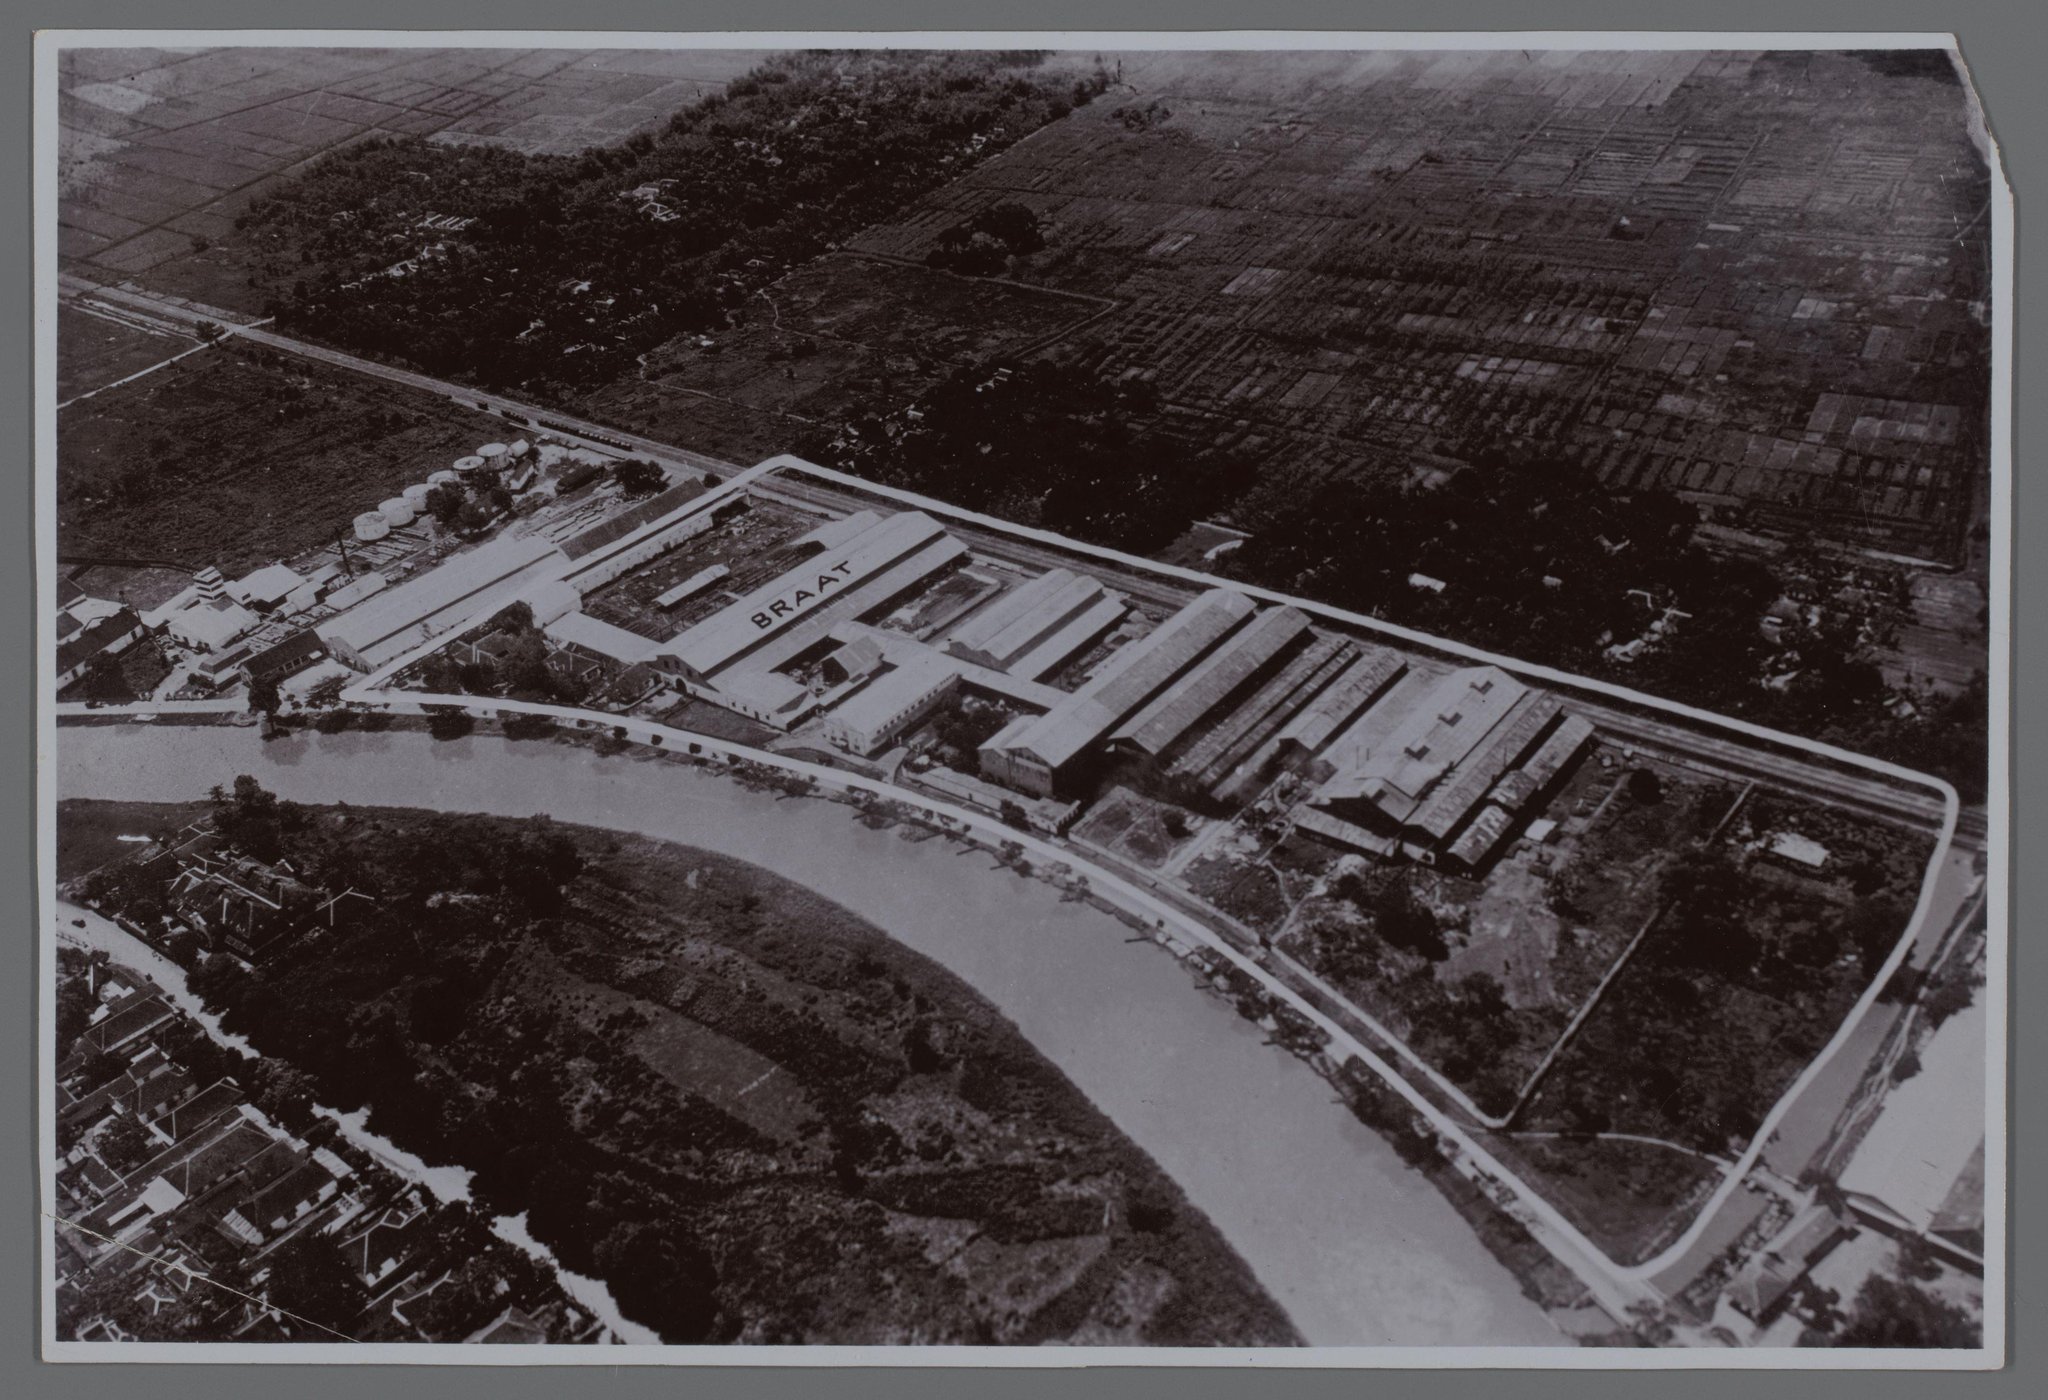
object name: aerial photograph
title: Machinefabriek Braat vanuit de lucht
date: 1905-1929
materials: photographic support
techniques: gelatin silver print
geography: surabaya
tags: colonial system, exterior of industrial structures, factories, java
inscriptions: date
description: Gezicht op het complex met de fabrieksgebouwen van de Machinefabriek Braat te Soerabaja, gezien vanuit de lucht, mei 1929. Onderdeel van de multomap met foto's van machines van de N.V. Machinefabriek Braat te Soerabaja, Soekaboemi en Jogyakarta, uit de periode 1908-1942.